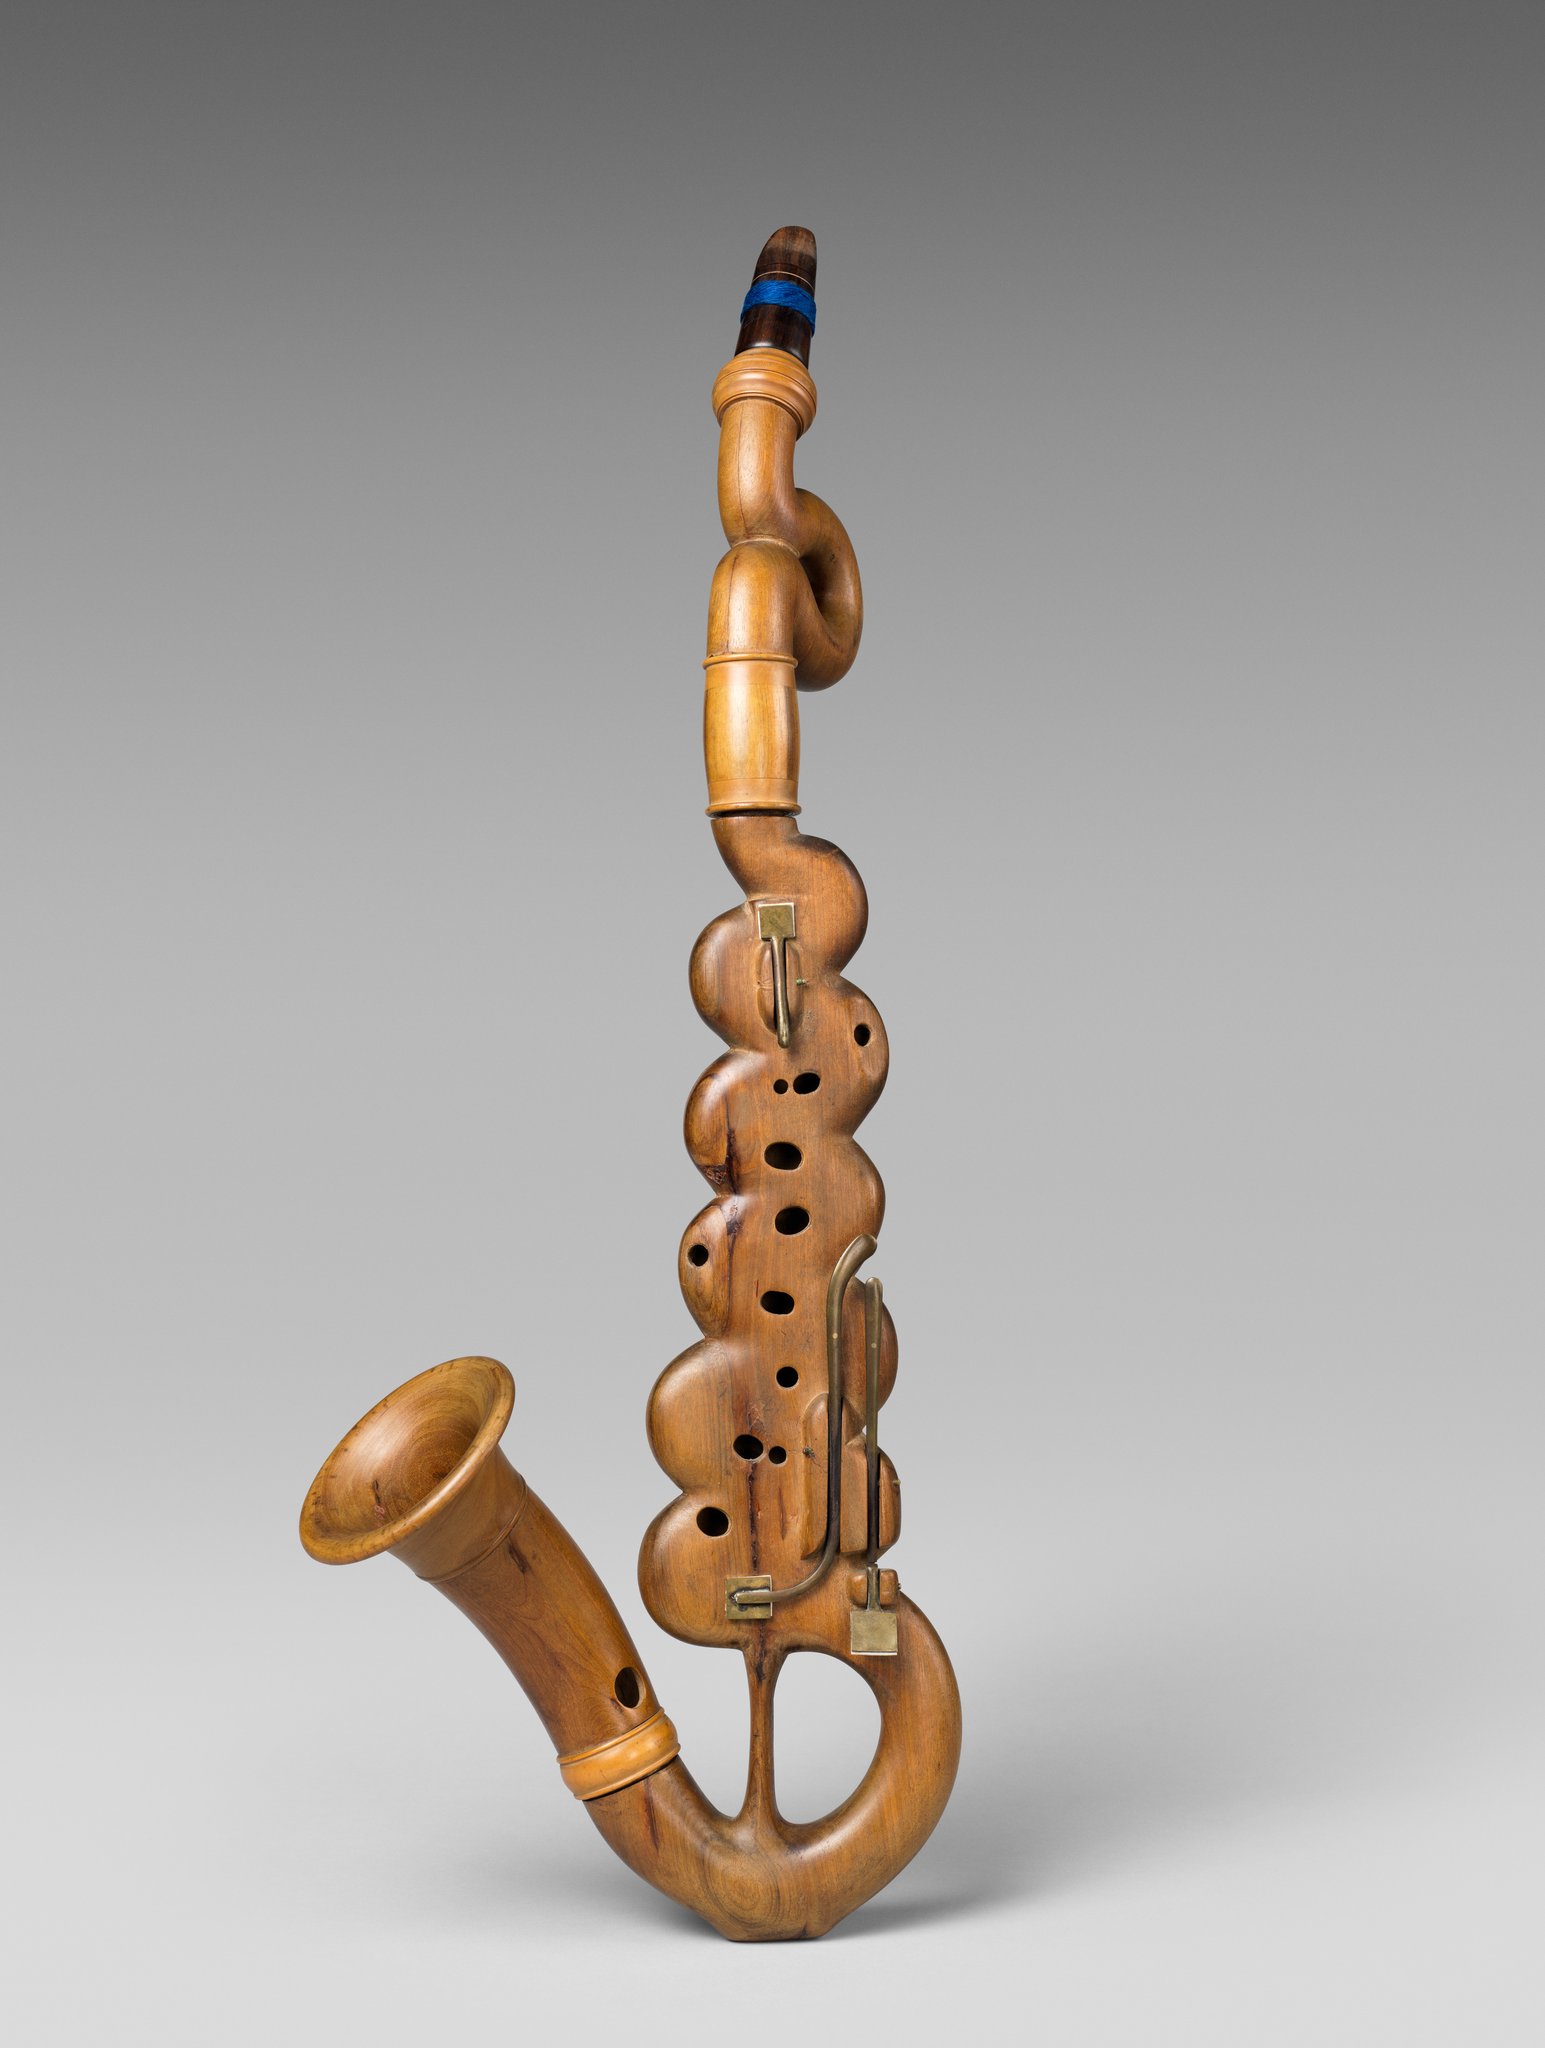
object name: bass clarinet in c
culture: italian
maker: nicola papalini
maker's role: maker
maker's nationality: italian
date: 1810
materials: brass, wood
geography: italy